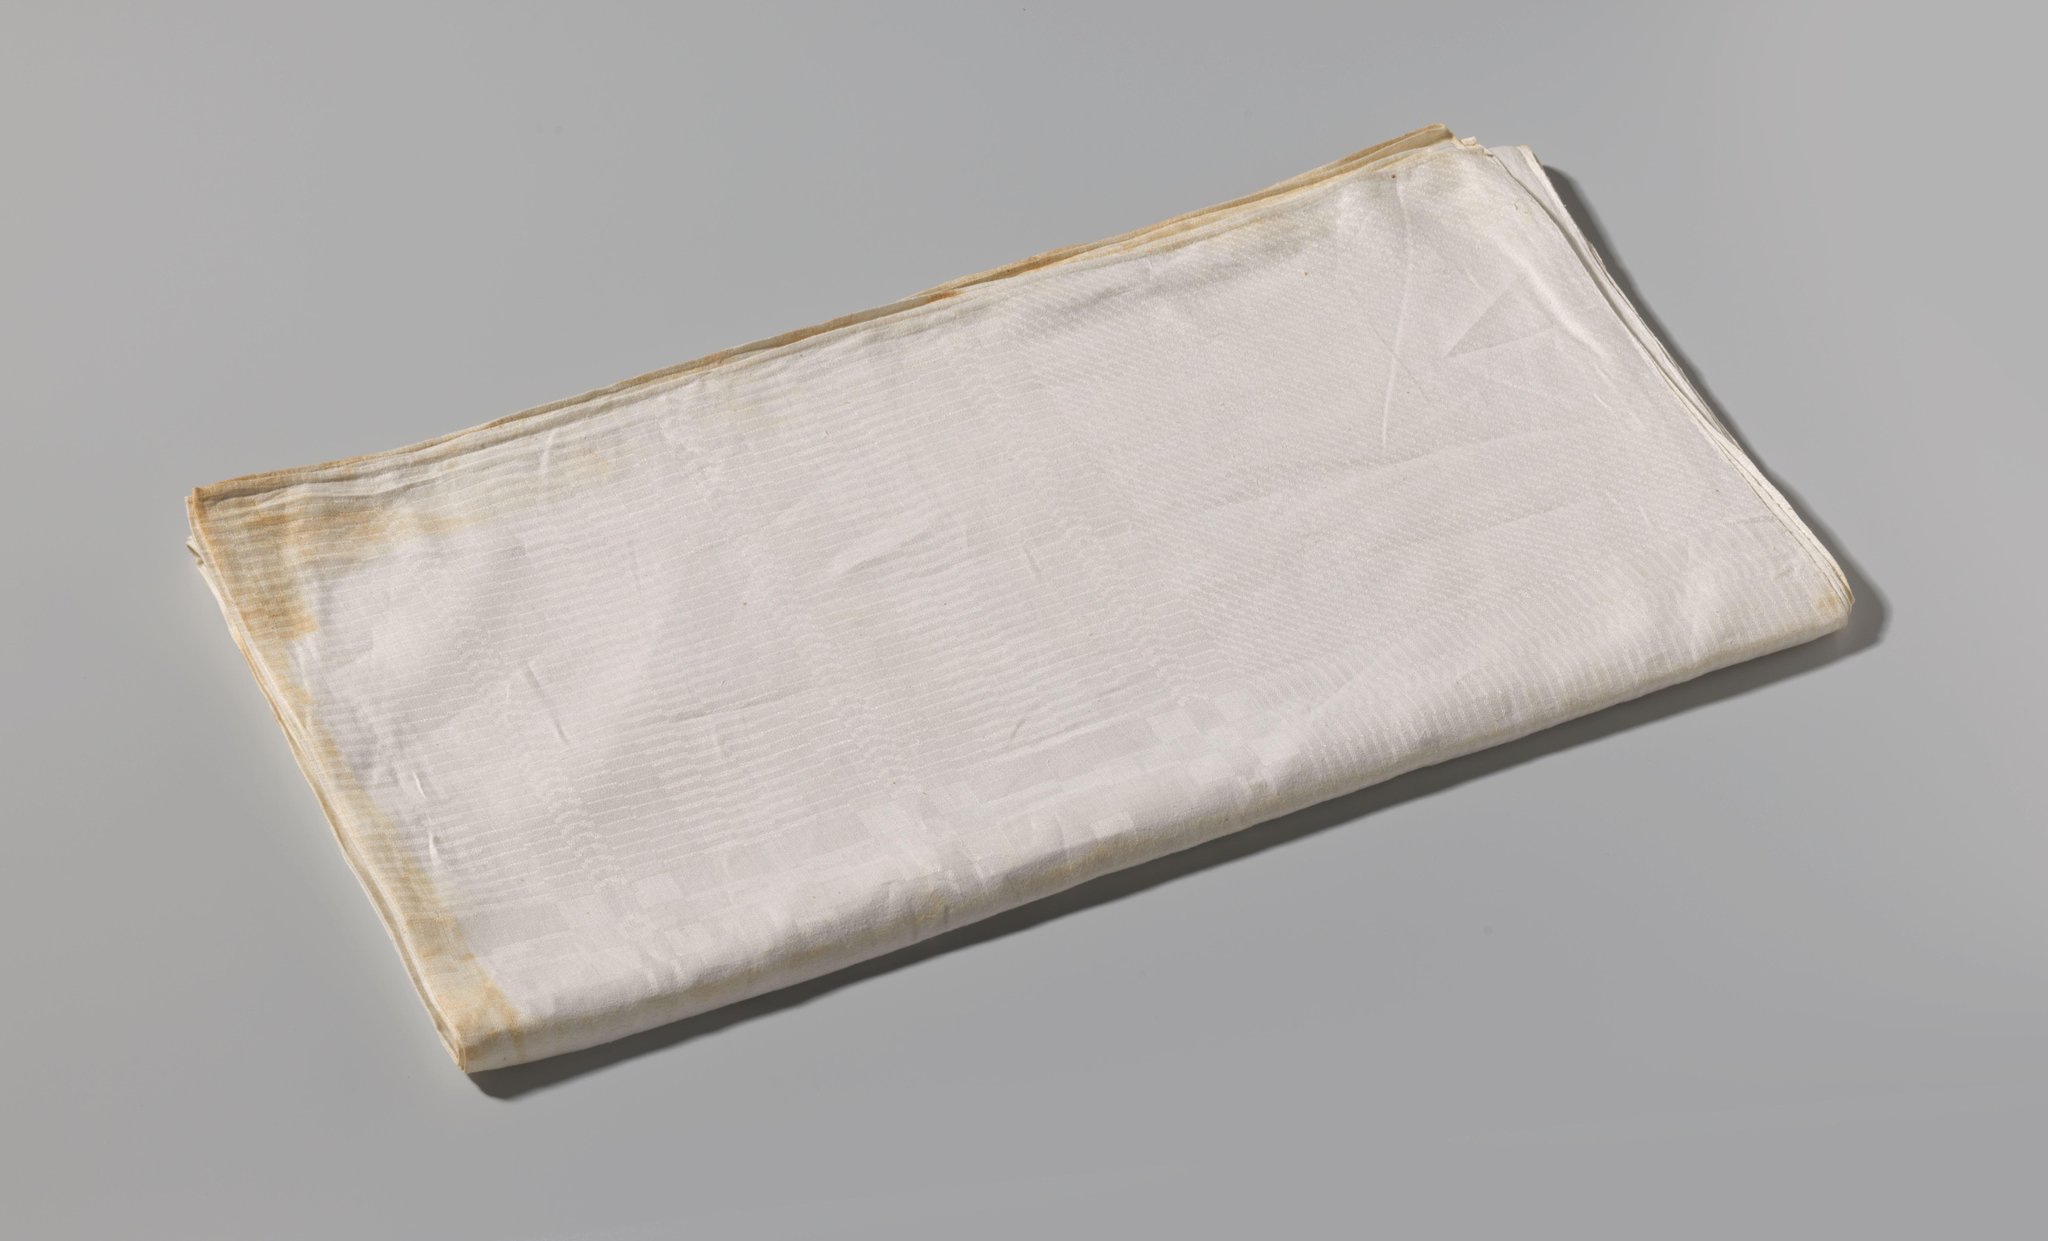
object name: tablecloth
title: Tafellaken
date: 1800-1899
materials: linen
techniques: peeled fabric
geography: netherlands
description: Wit linnen tafellaken met pellen patroon 'uitgehouwen steen of hoekster' en randen WH 2oonl.